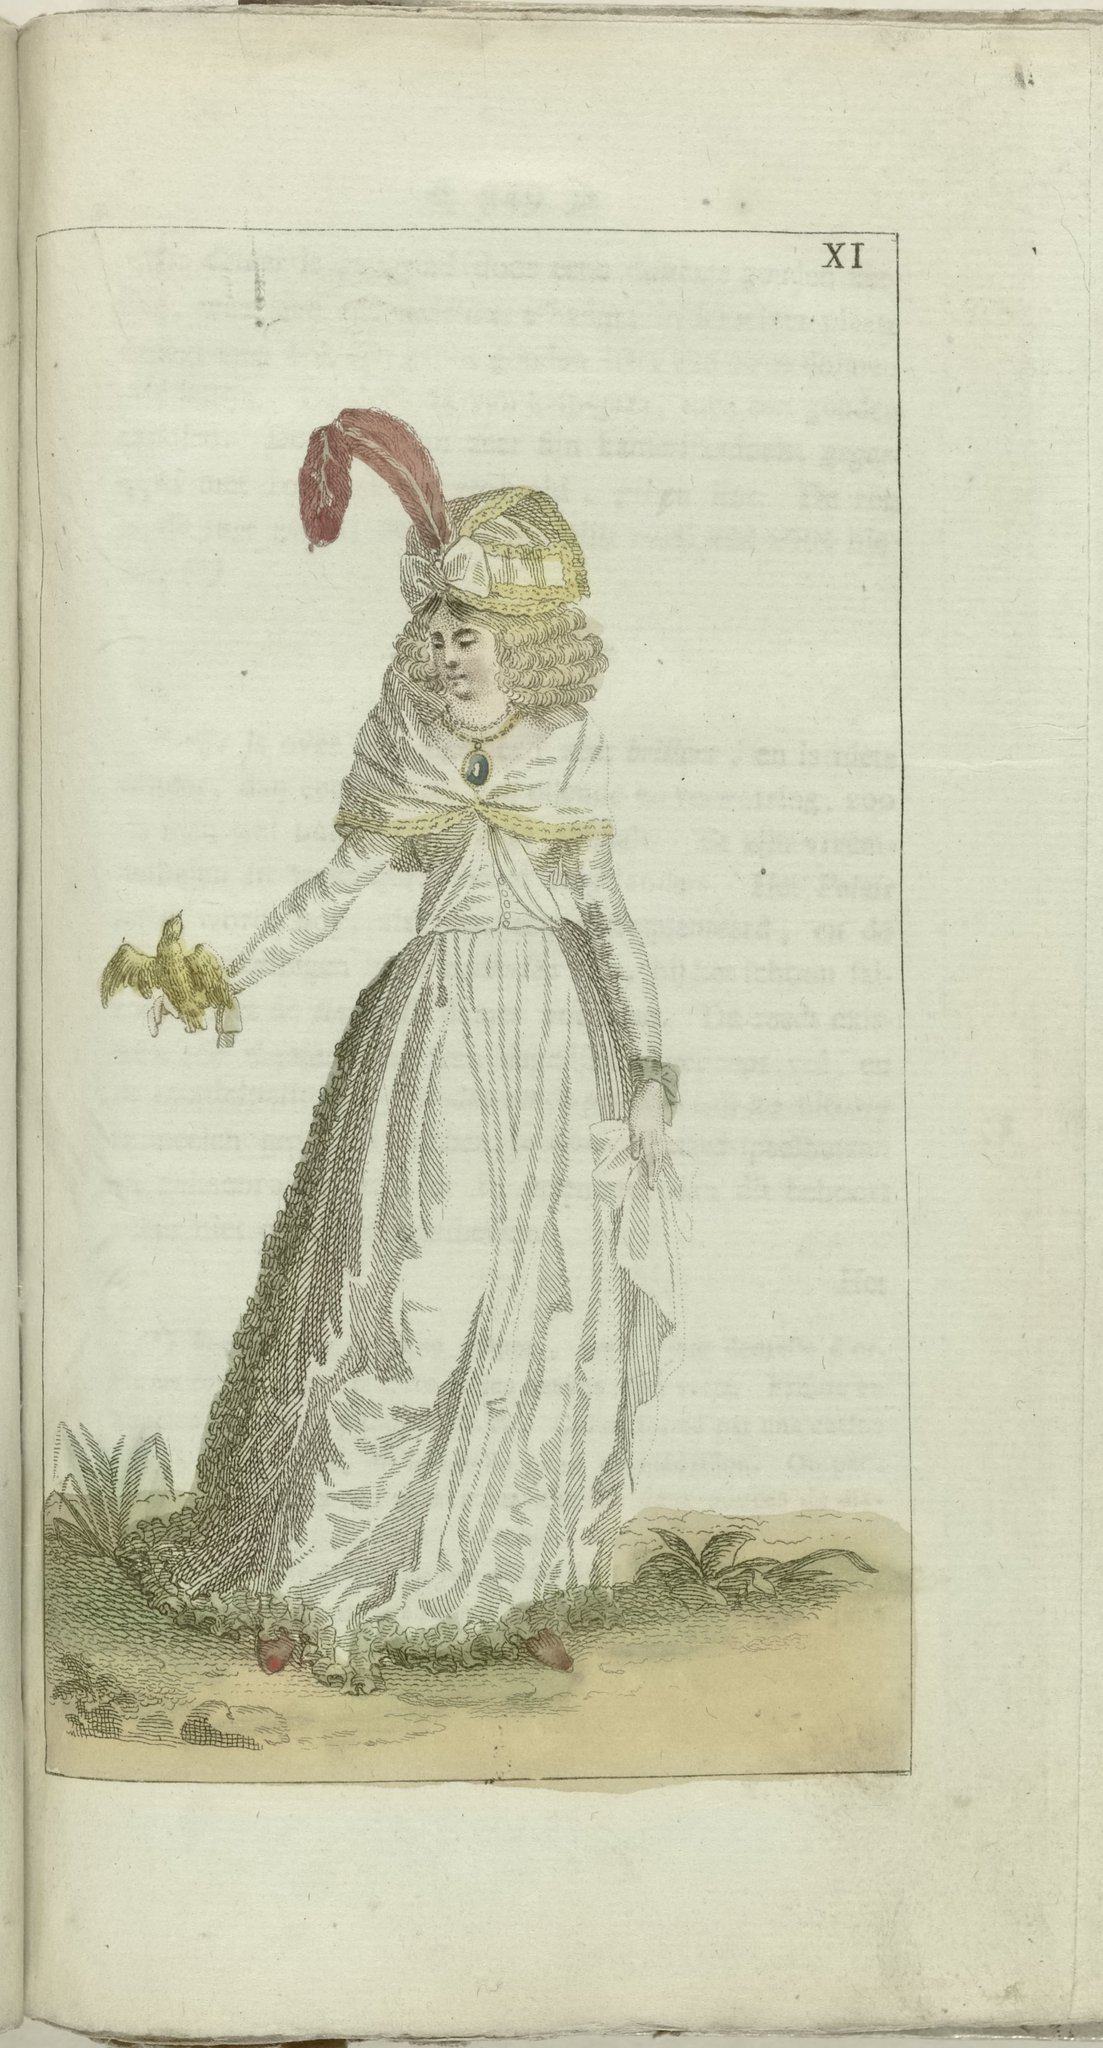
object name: fashion print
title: Kabinet van mode en smaak 1791, pl. XI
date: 1791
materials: paper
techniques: etching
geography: haarlem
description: vrouw met bonnet-fichu van krip gaas.... p. 348